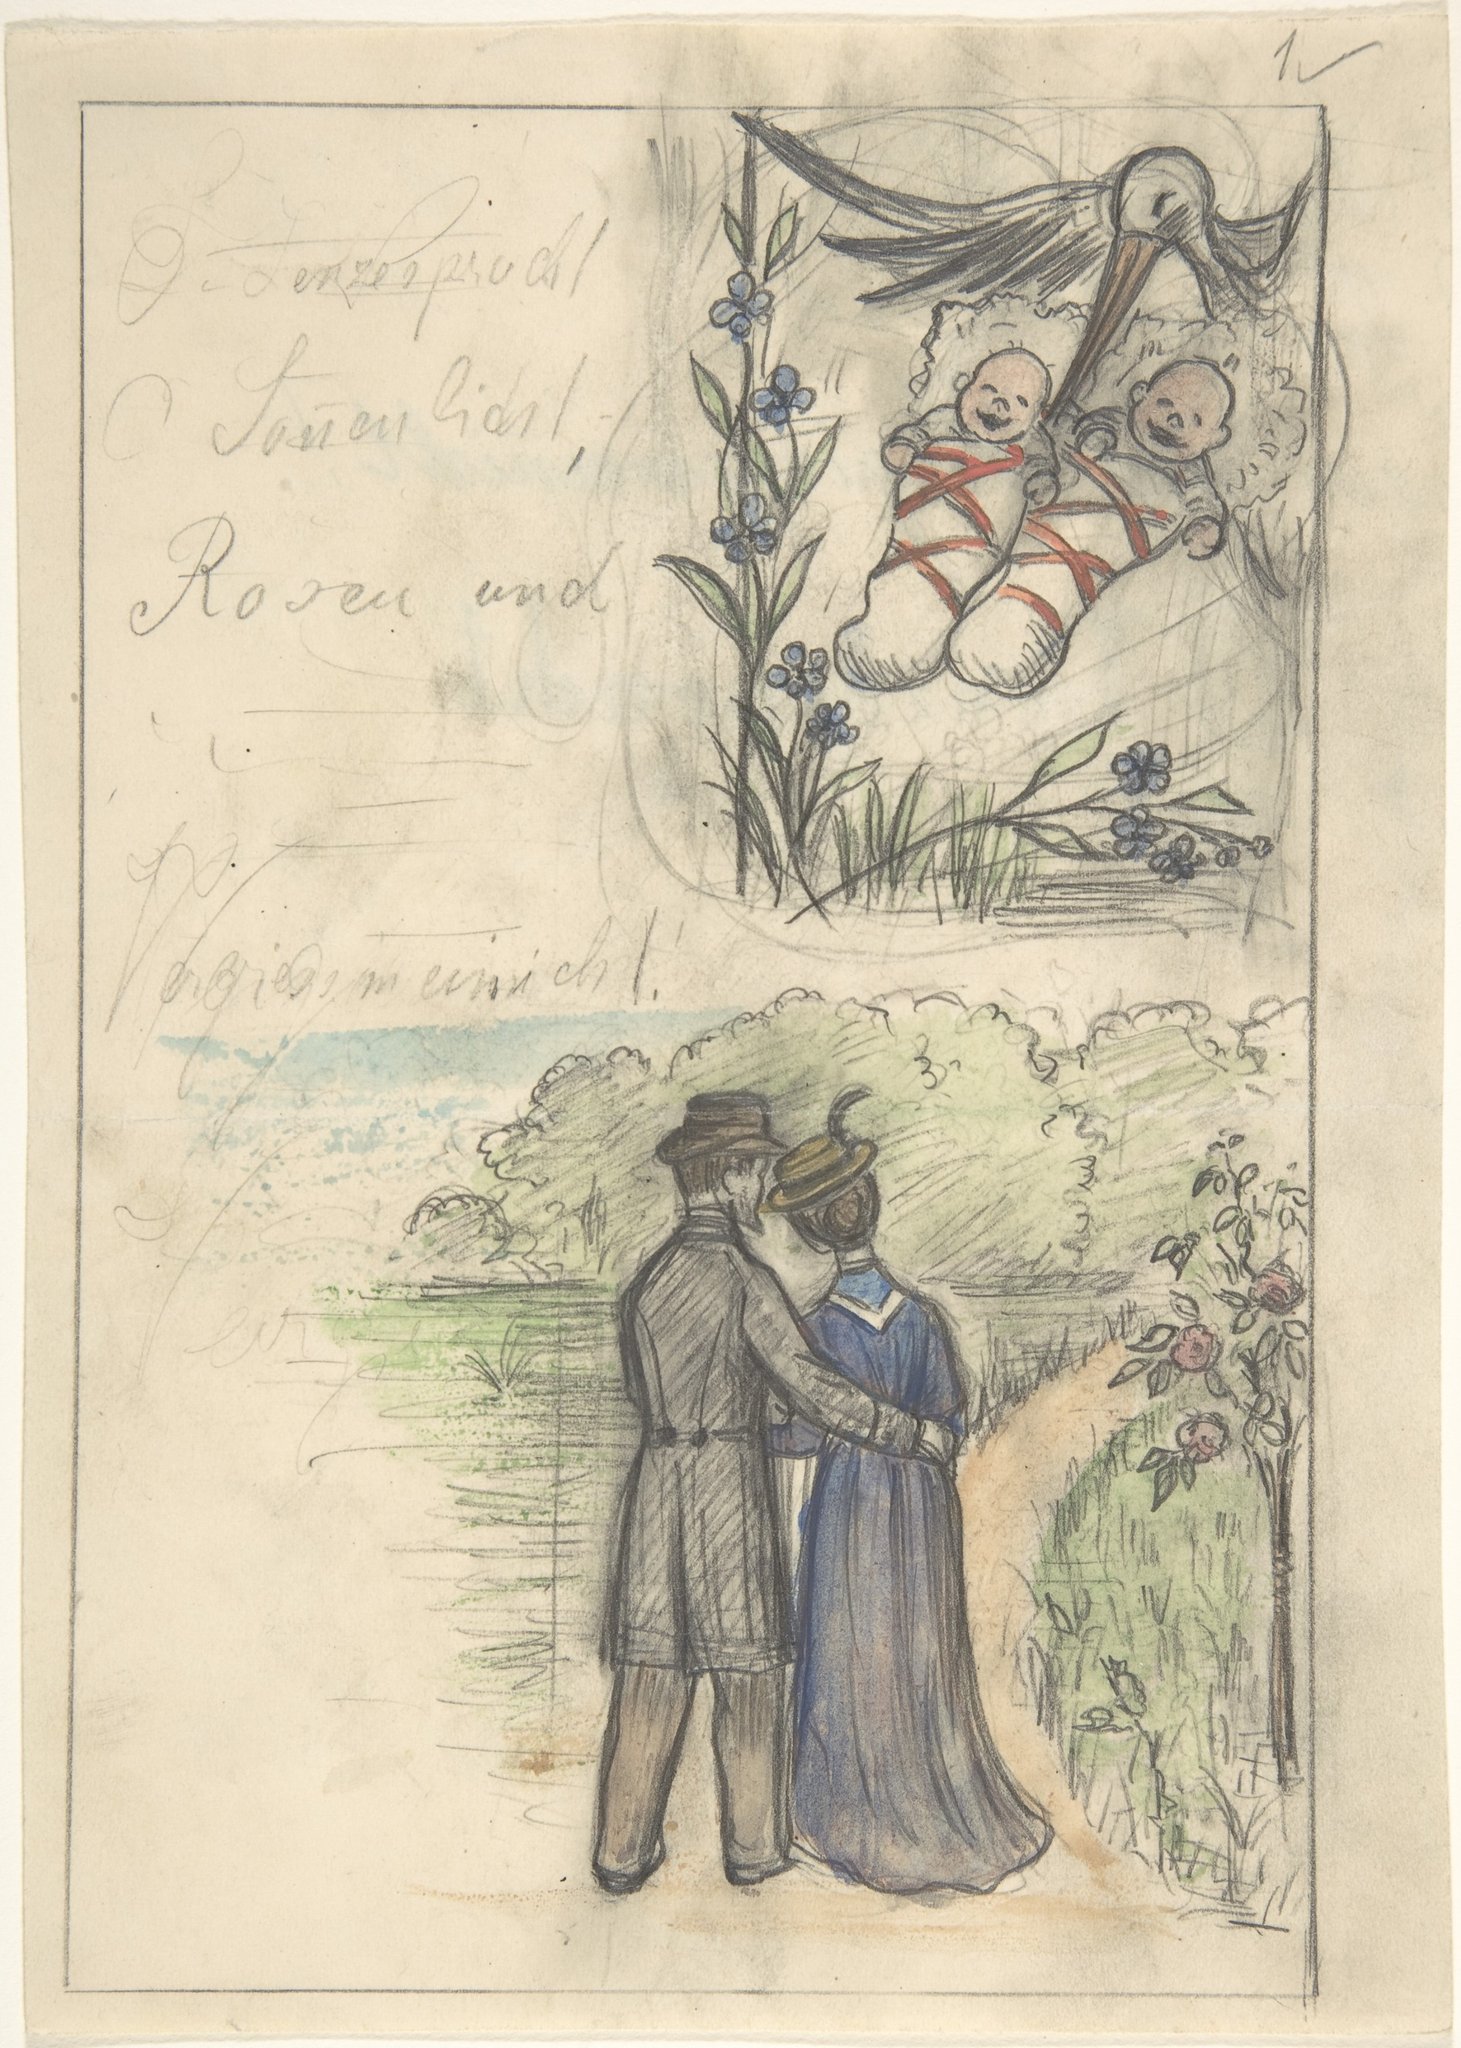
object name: drawing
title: Study for a Birth Announcement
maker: anonymous, german, 19th century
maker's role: artist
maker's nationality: german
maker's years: 1800-1899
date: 1801-1900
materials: chalk, graphite, watercolor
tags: infants,men,women,plants